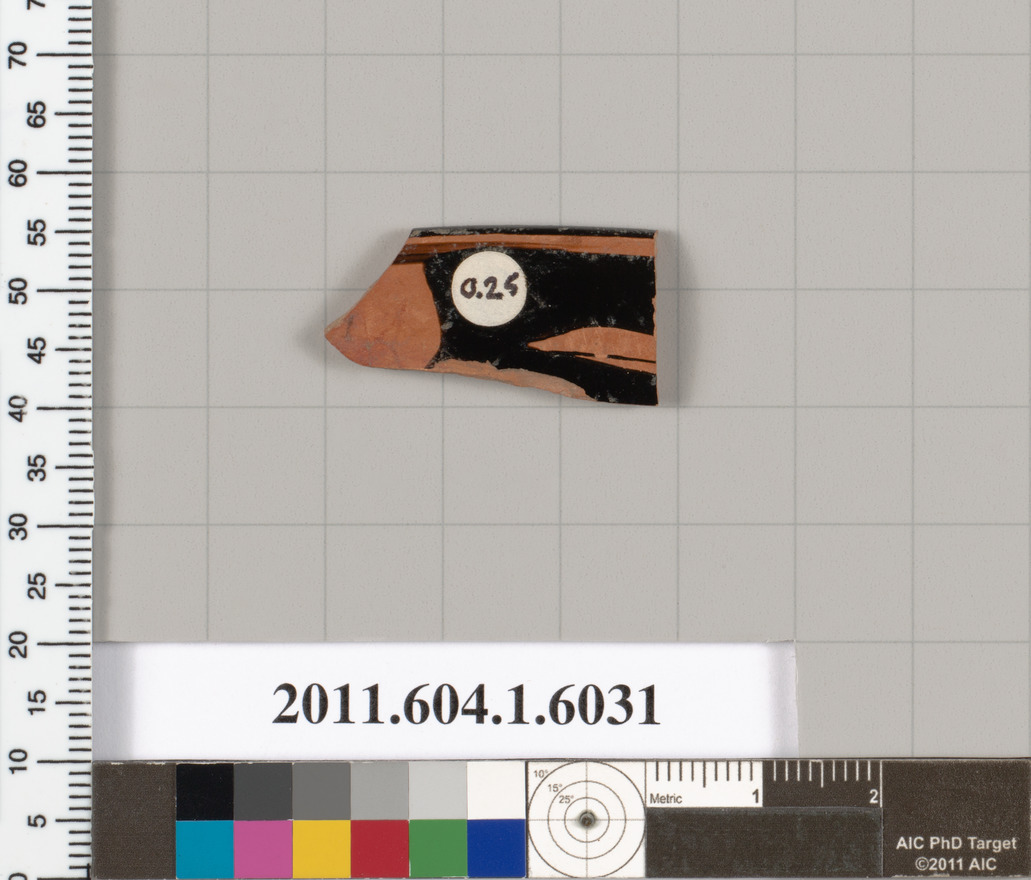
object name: kylix fragment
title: Terracotta rim fragment of a kylix (drinking cup)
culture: greek, attic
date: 510-500 BCE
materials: terracotta